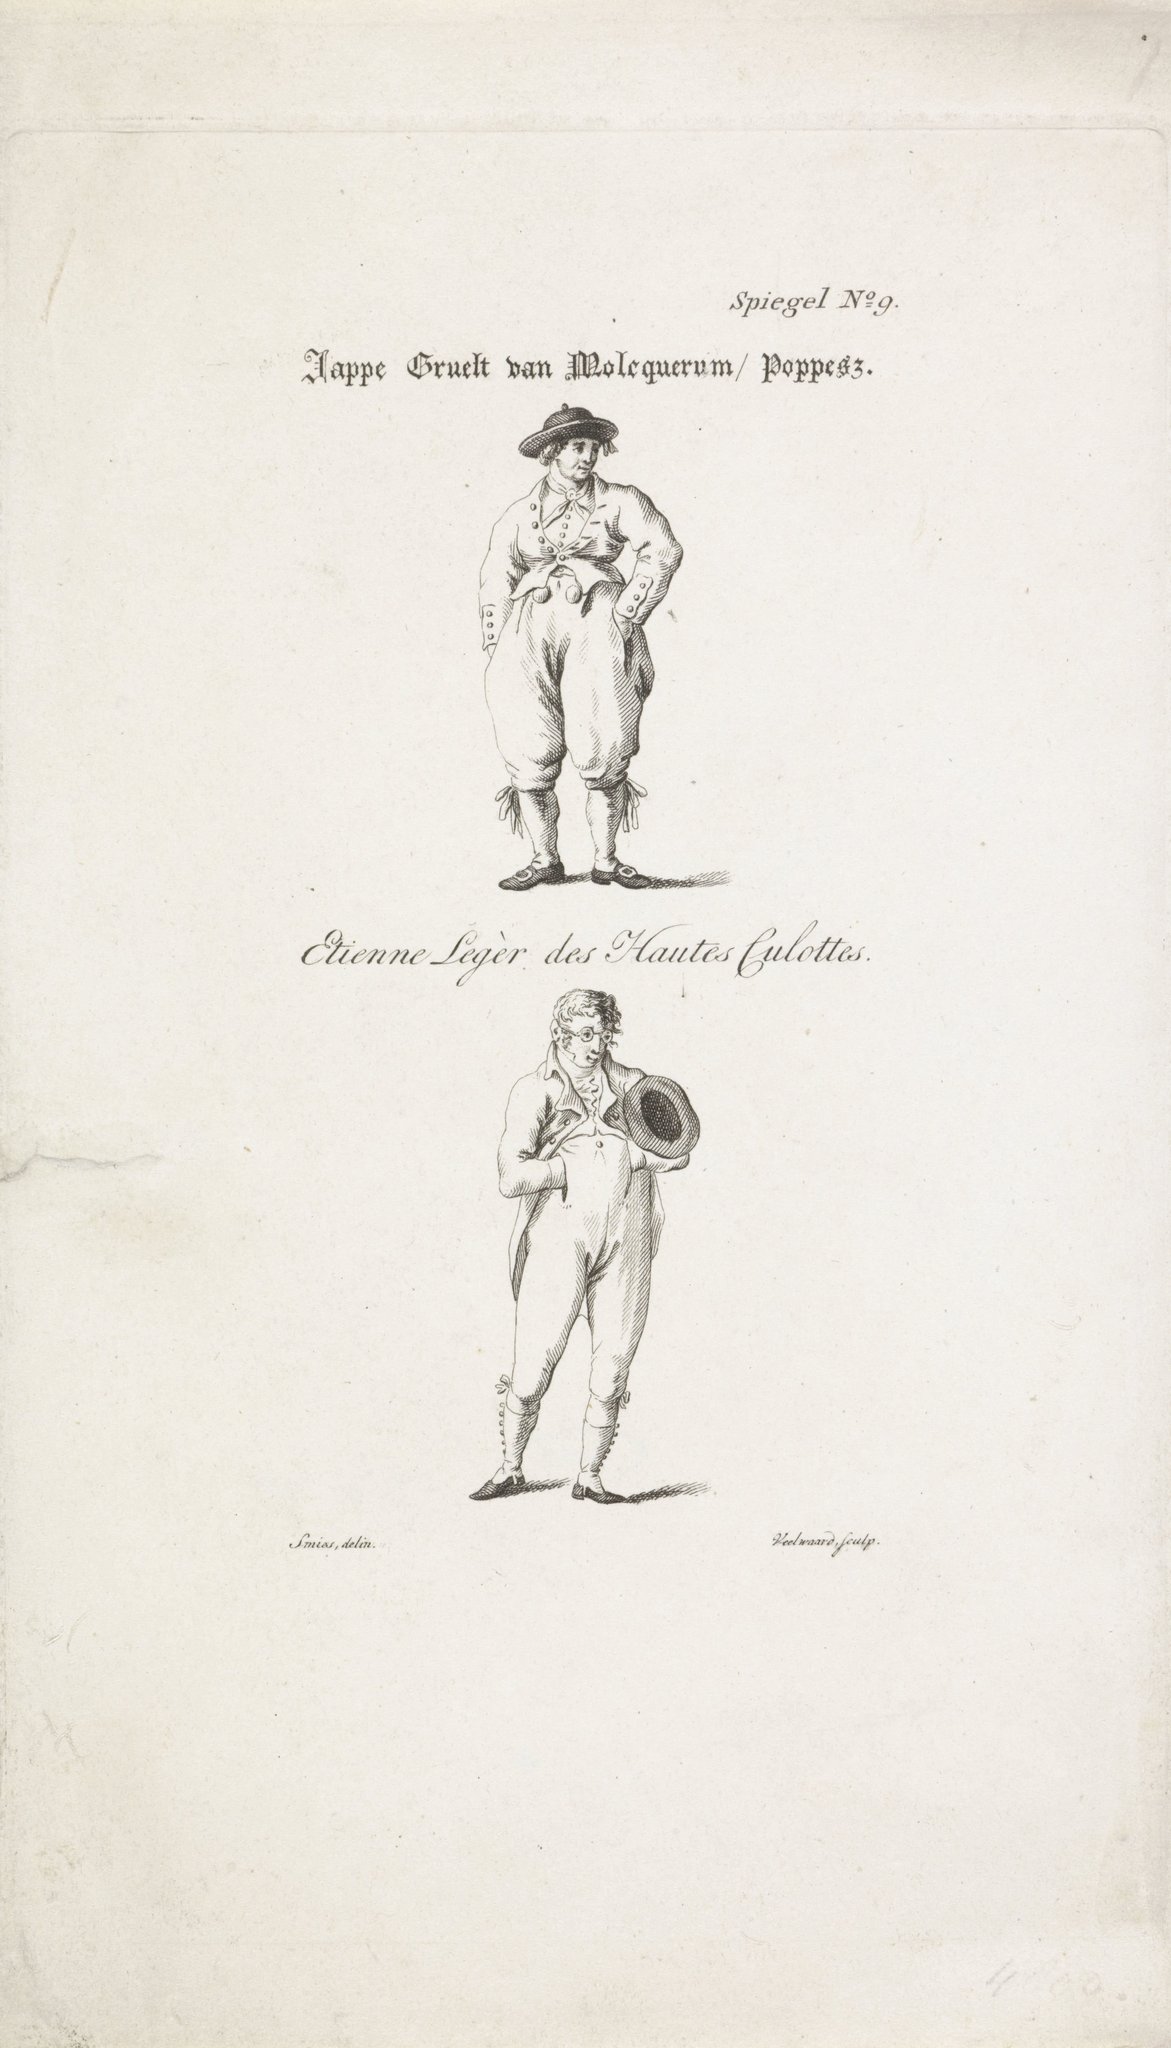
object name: print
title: Jappe Gruelt van Molcquerum, Poppesz. / Etienne Legèr des Hautes Culottes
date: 1790-1800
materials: paper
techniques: etching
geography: netherlands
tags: folk costume, regional costume, france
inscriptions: collector's mark: Lugt 2228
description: Volgens Muller mogelijk gebruikt als illustratie in: Spiegel voor 't Menschdom. Amsterdam: Moolenijzer, 2 dln, 1794-1796 (?)